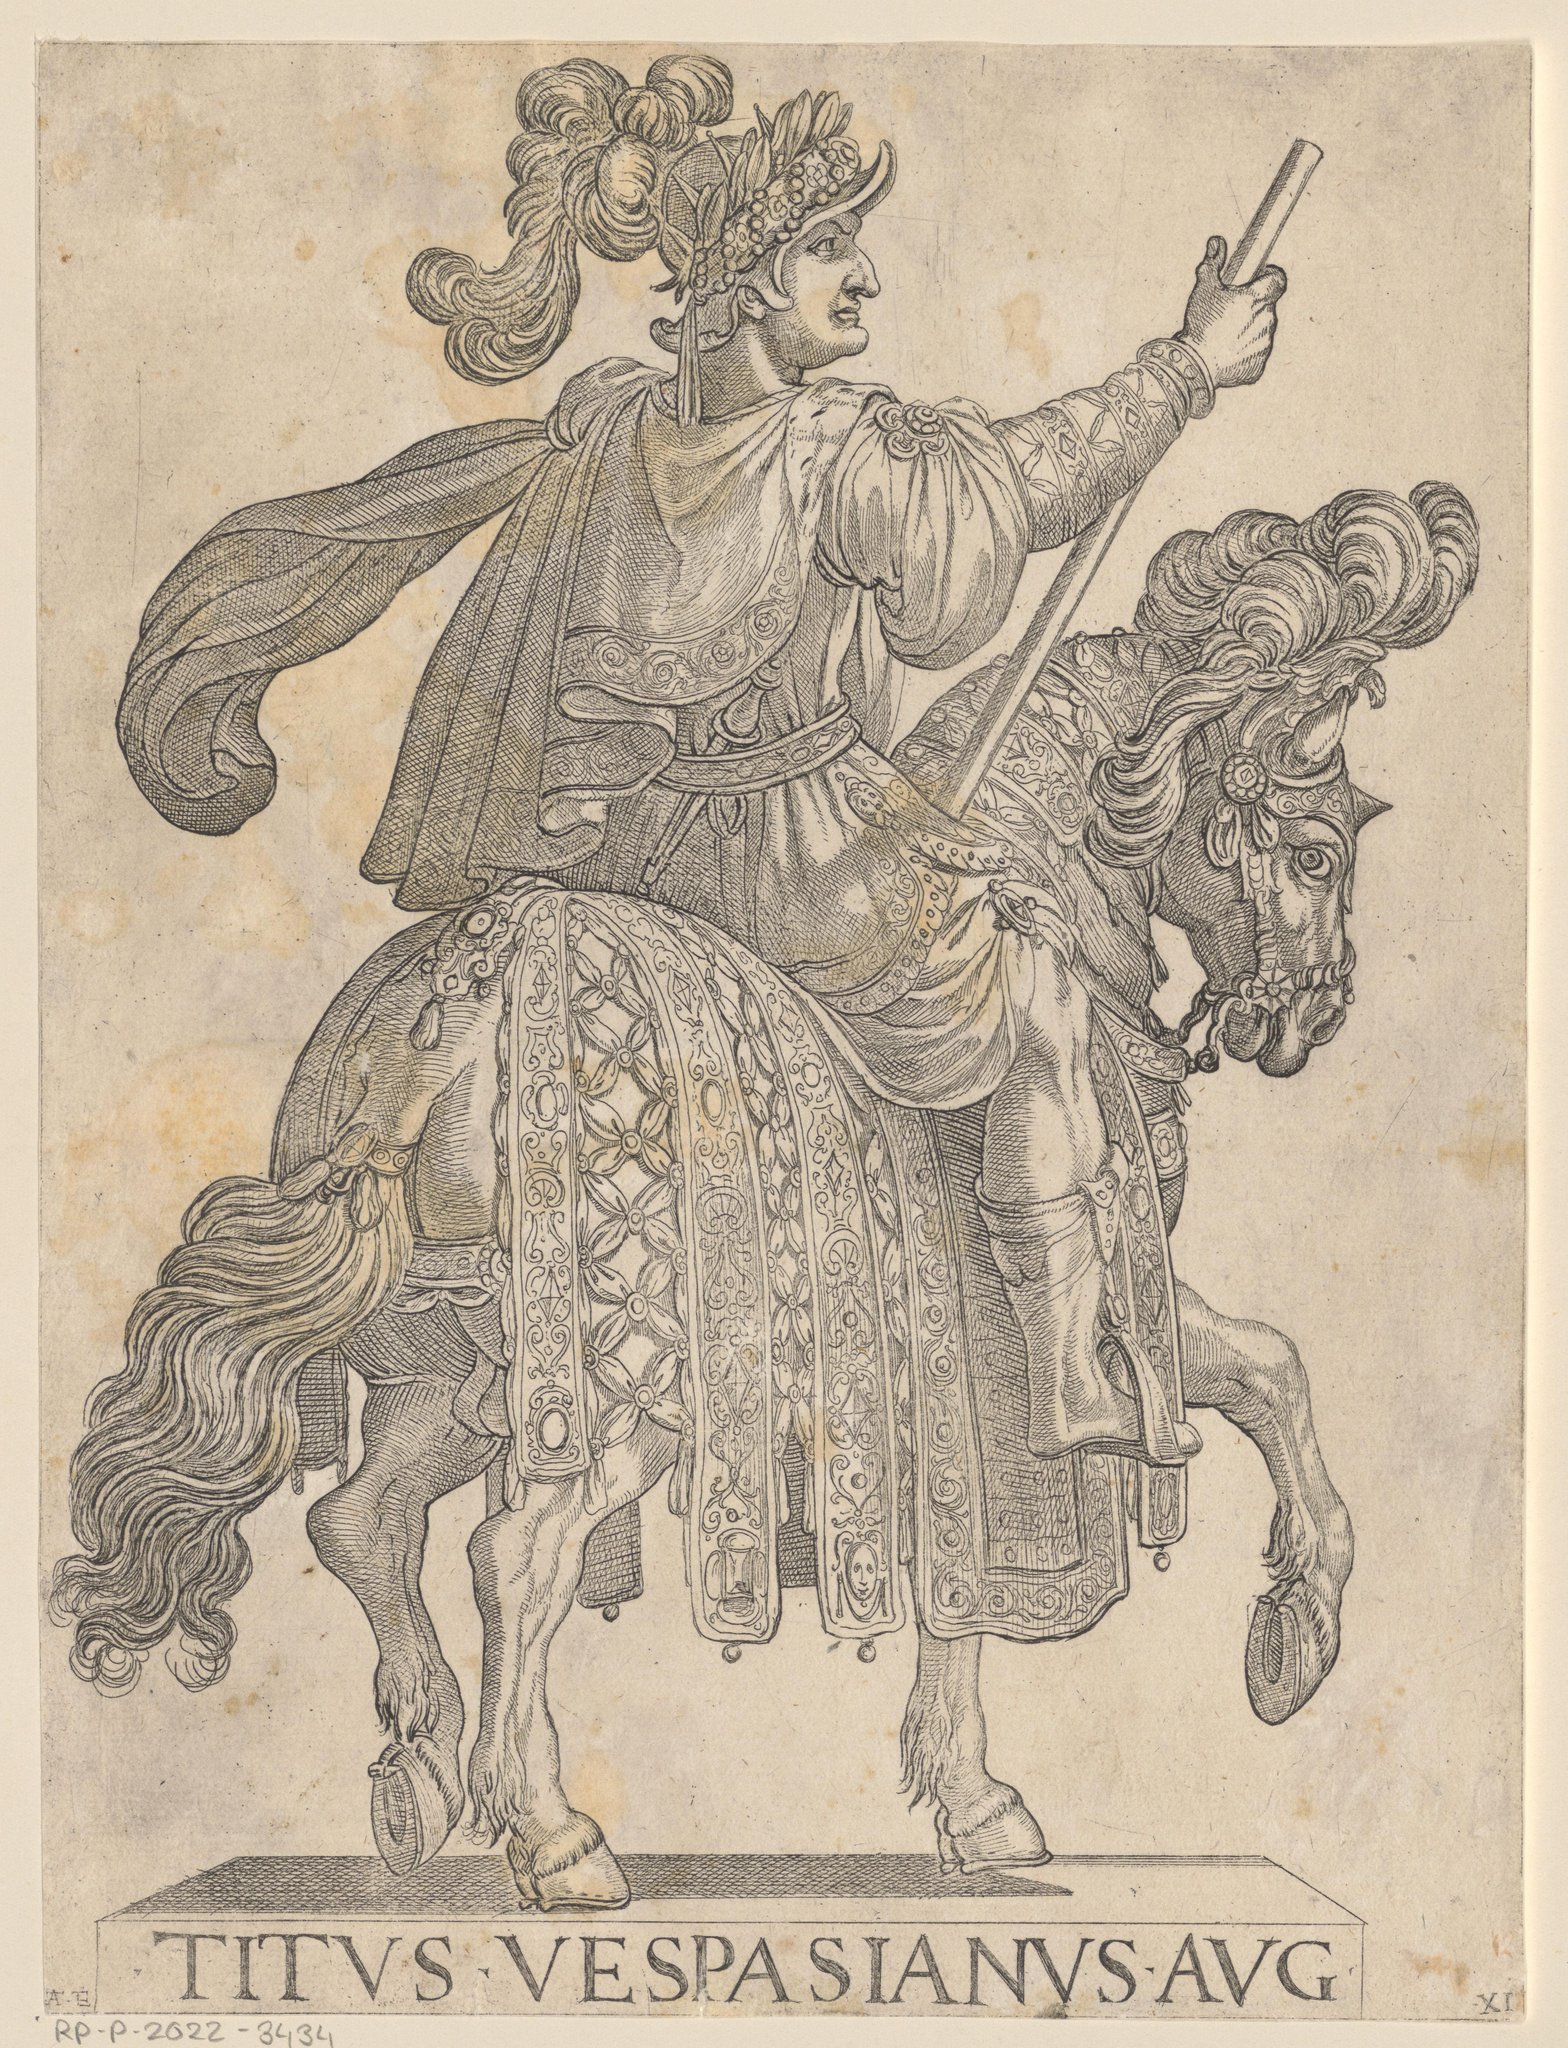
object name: print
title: Eerste twaalf Romeinse keizers te paard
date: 1596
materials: paper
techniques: etching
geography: italy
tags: rome, equestrian state-portrait, (story of) the emperor titus - portrait of person from classical history, historical persons, emperor